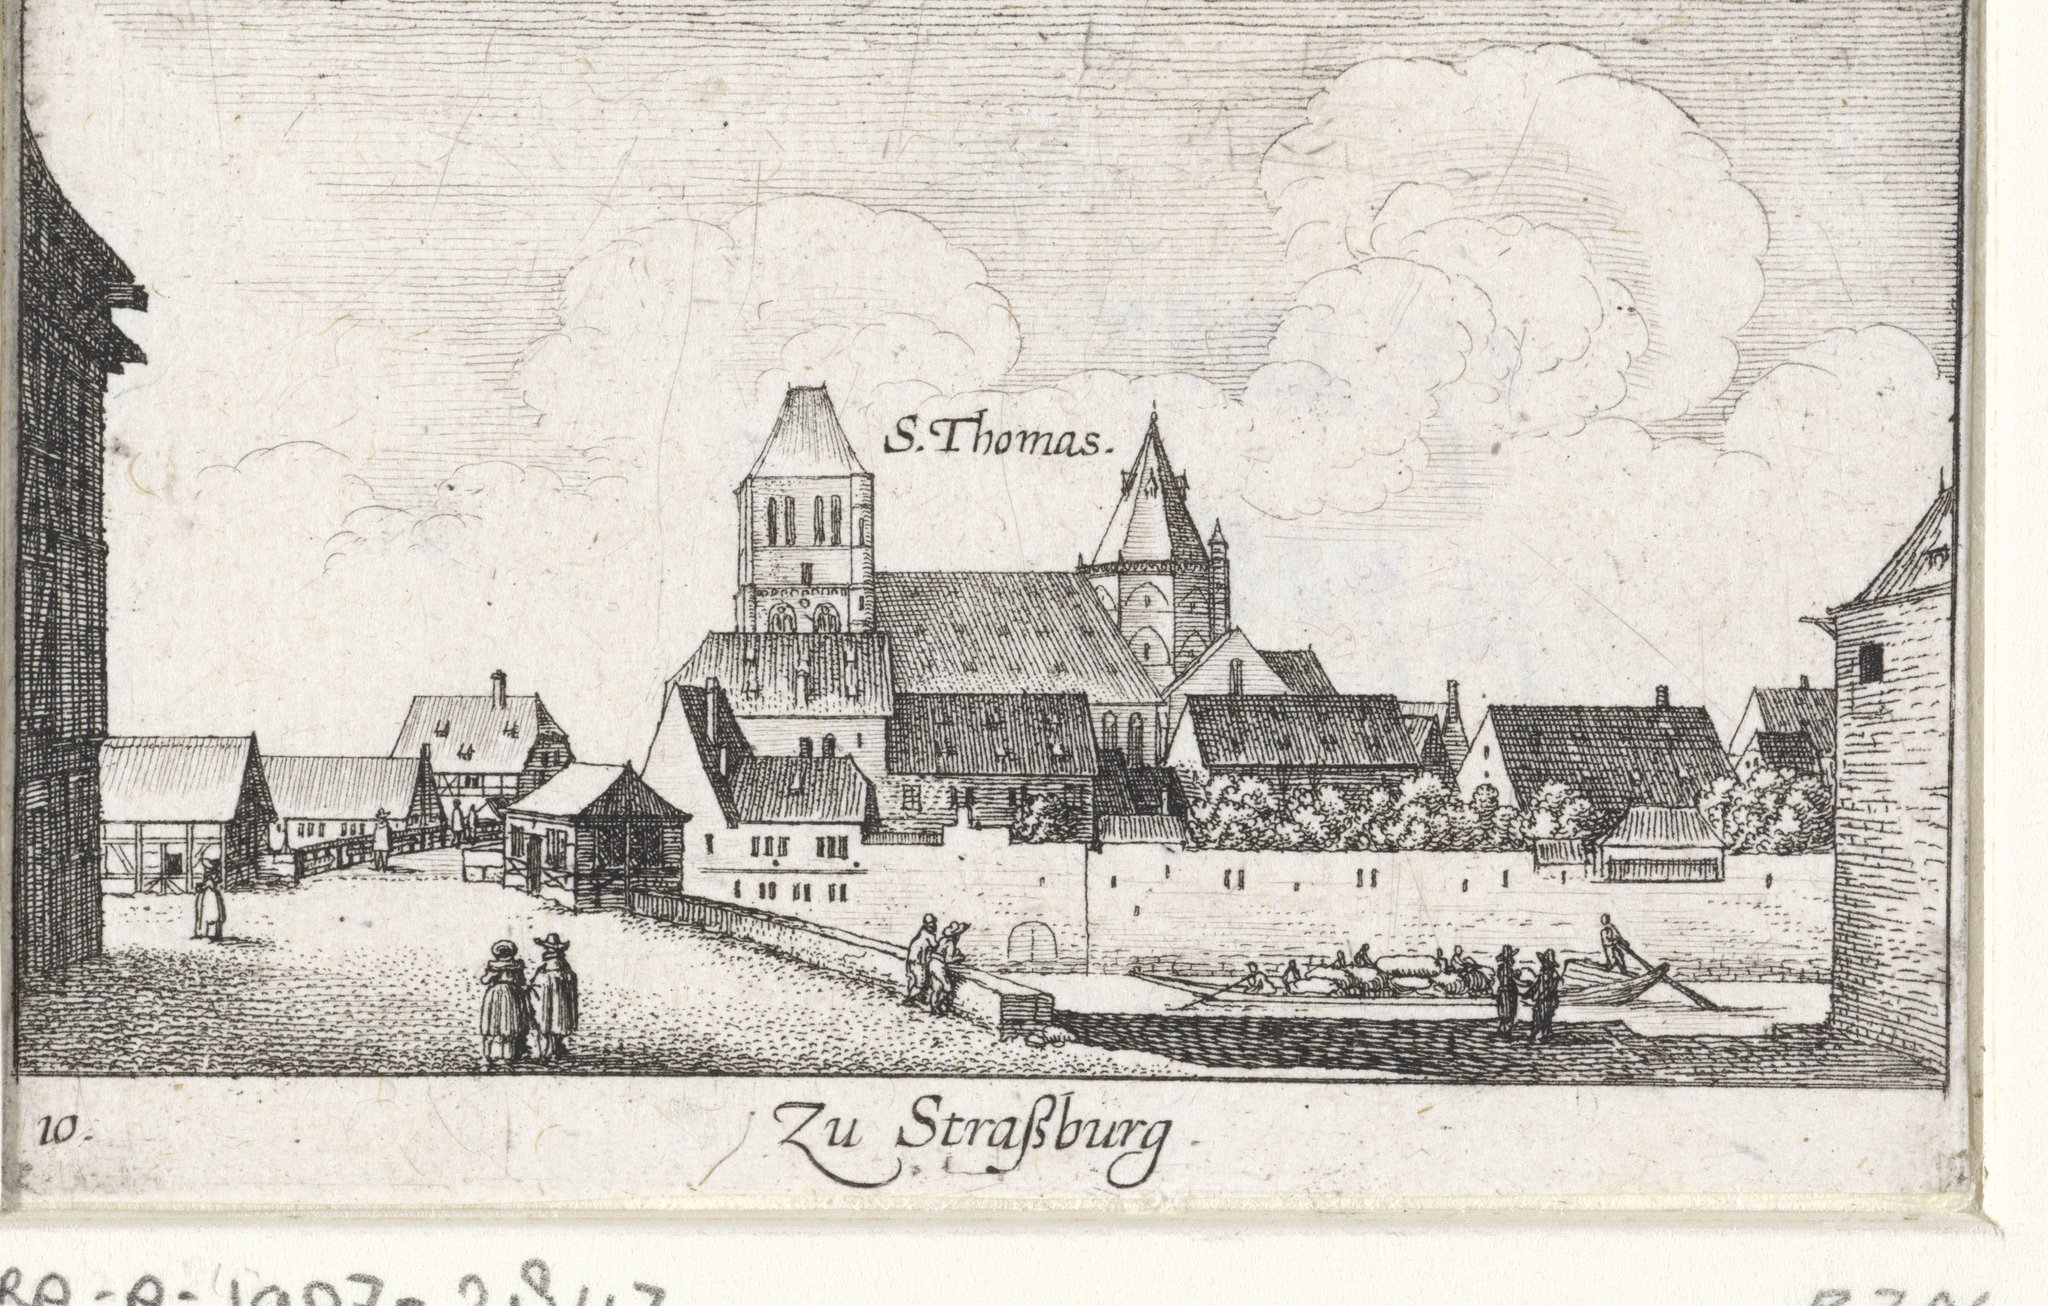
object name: print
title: Zu Strassburg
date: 1635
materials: paper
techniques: etching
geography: cologne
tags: city-view, and landscape with man-made constructions